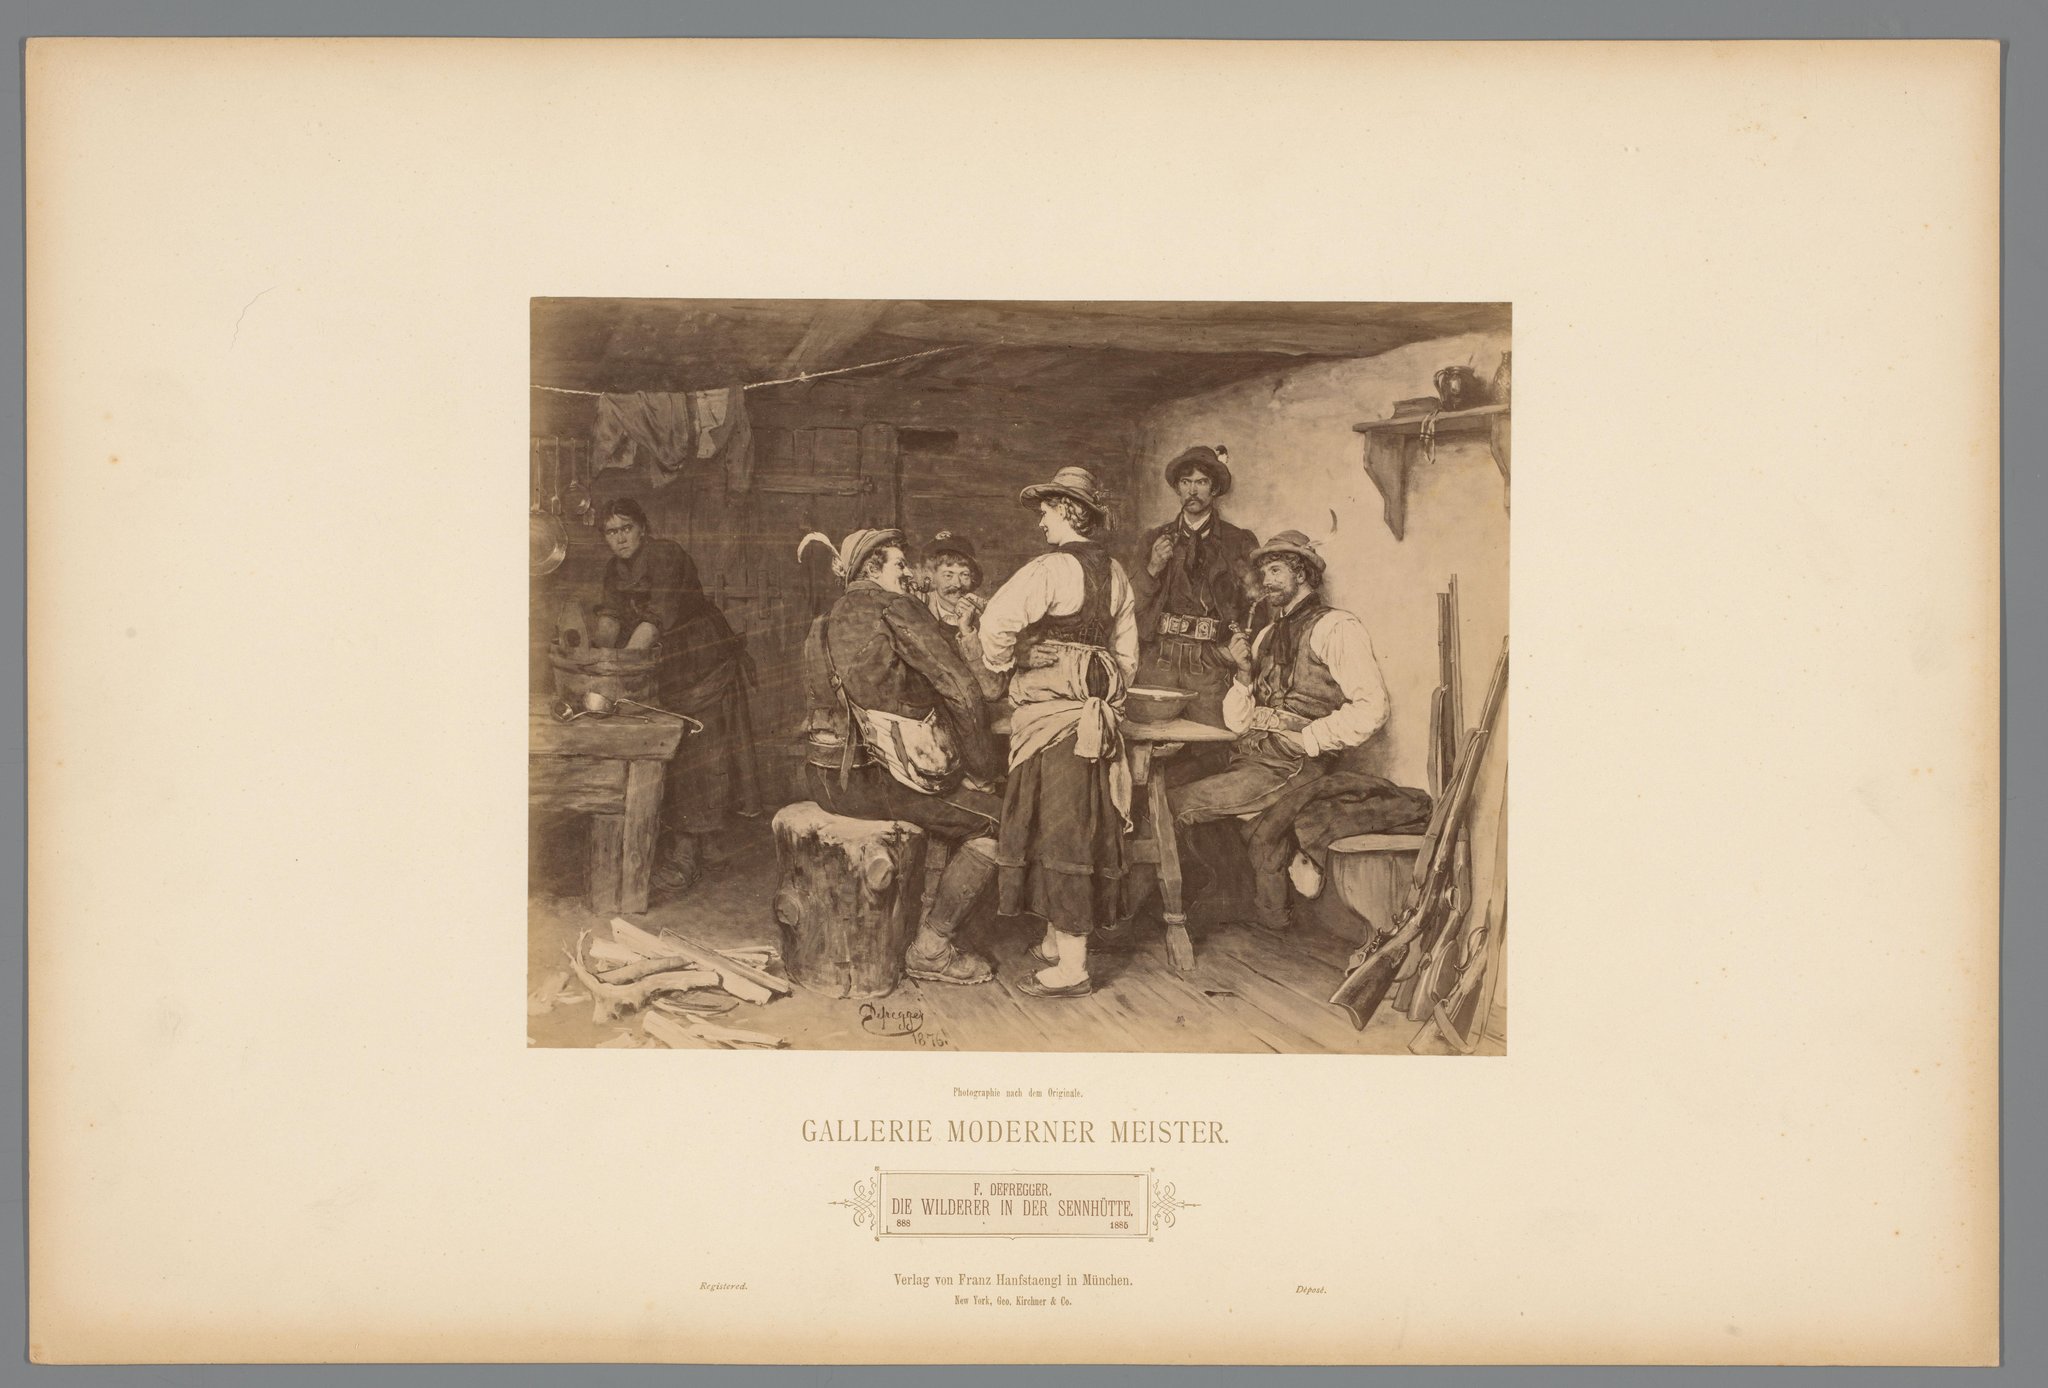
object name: photograph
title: Die Wilderer in der Sennhütte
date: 1885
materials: cardboard, photographic support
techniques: albumen print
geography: new york city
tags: poacher, inn, coffee-house, public house, etc.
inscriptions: inscription: ‘F. DEFREGGER/ DIE WILDERER IN DER SENNHÜTTE./ 888 1885’, inscription: ‘Registered. - Déposé.’, inscription: ‘Photographie nach dem Originale.’